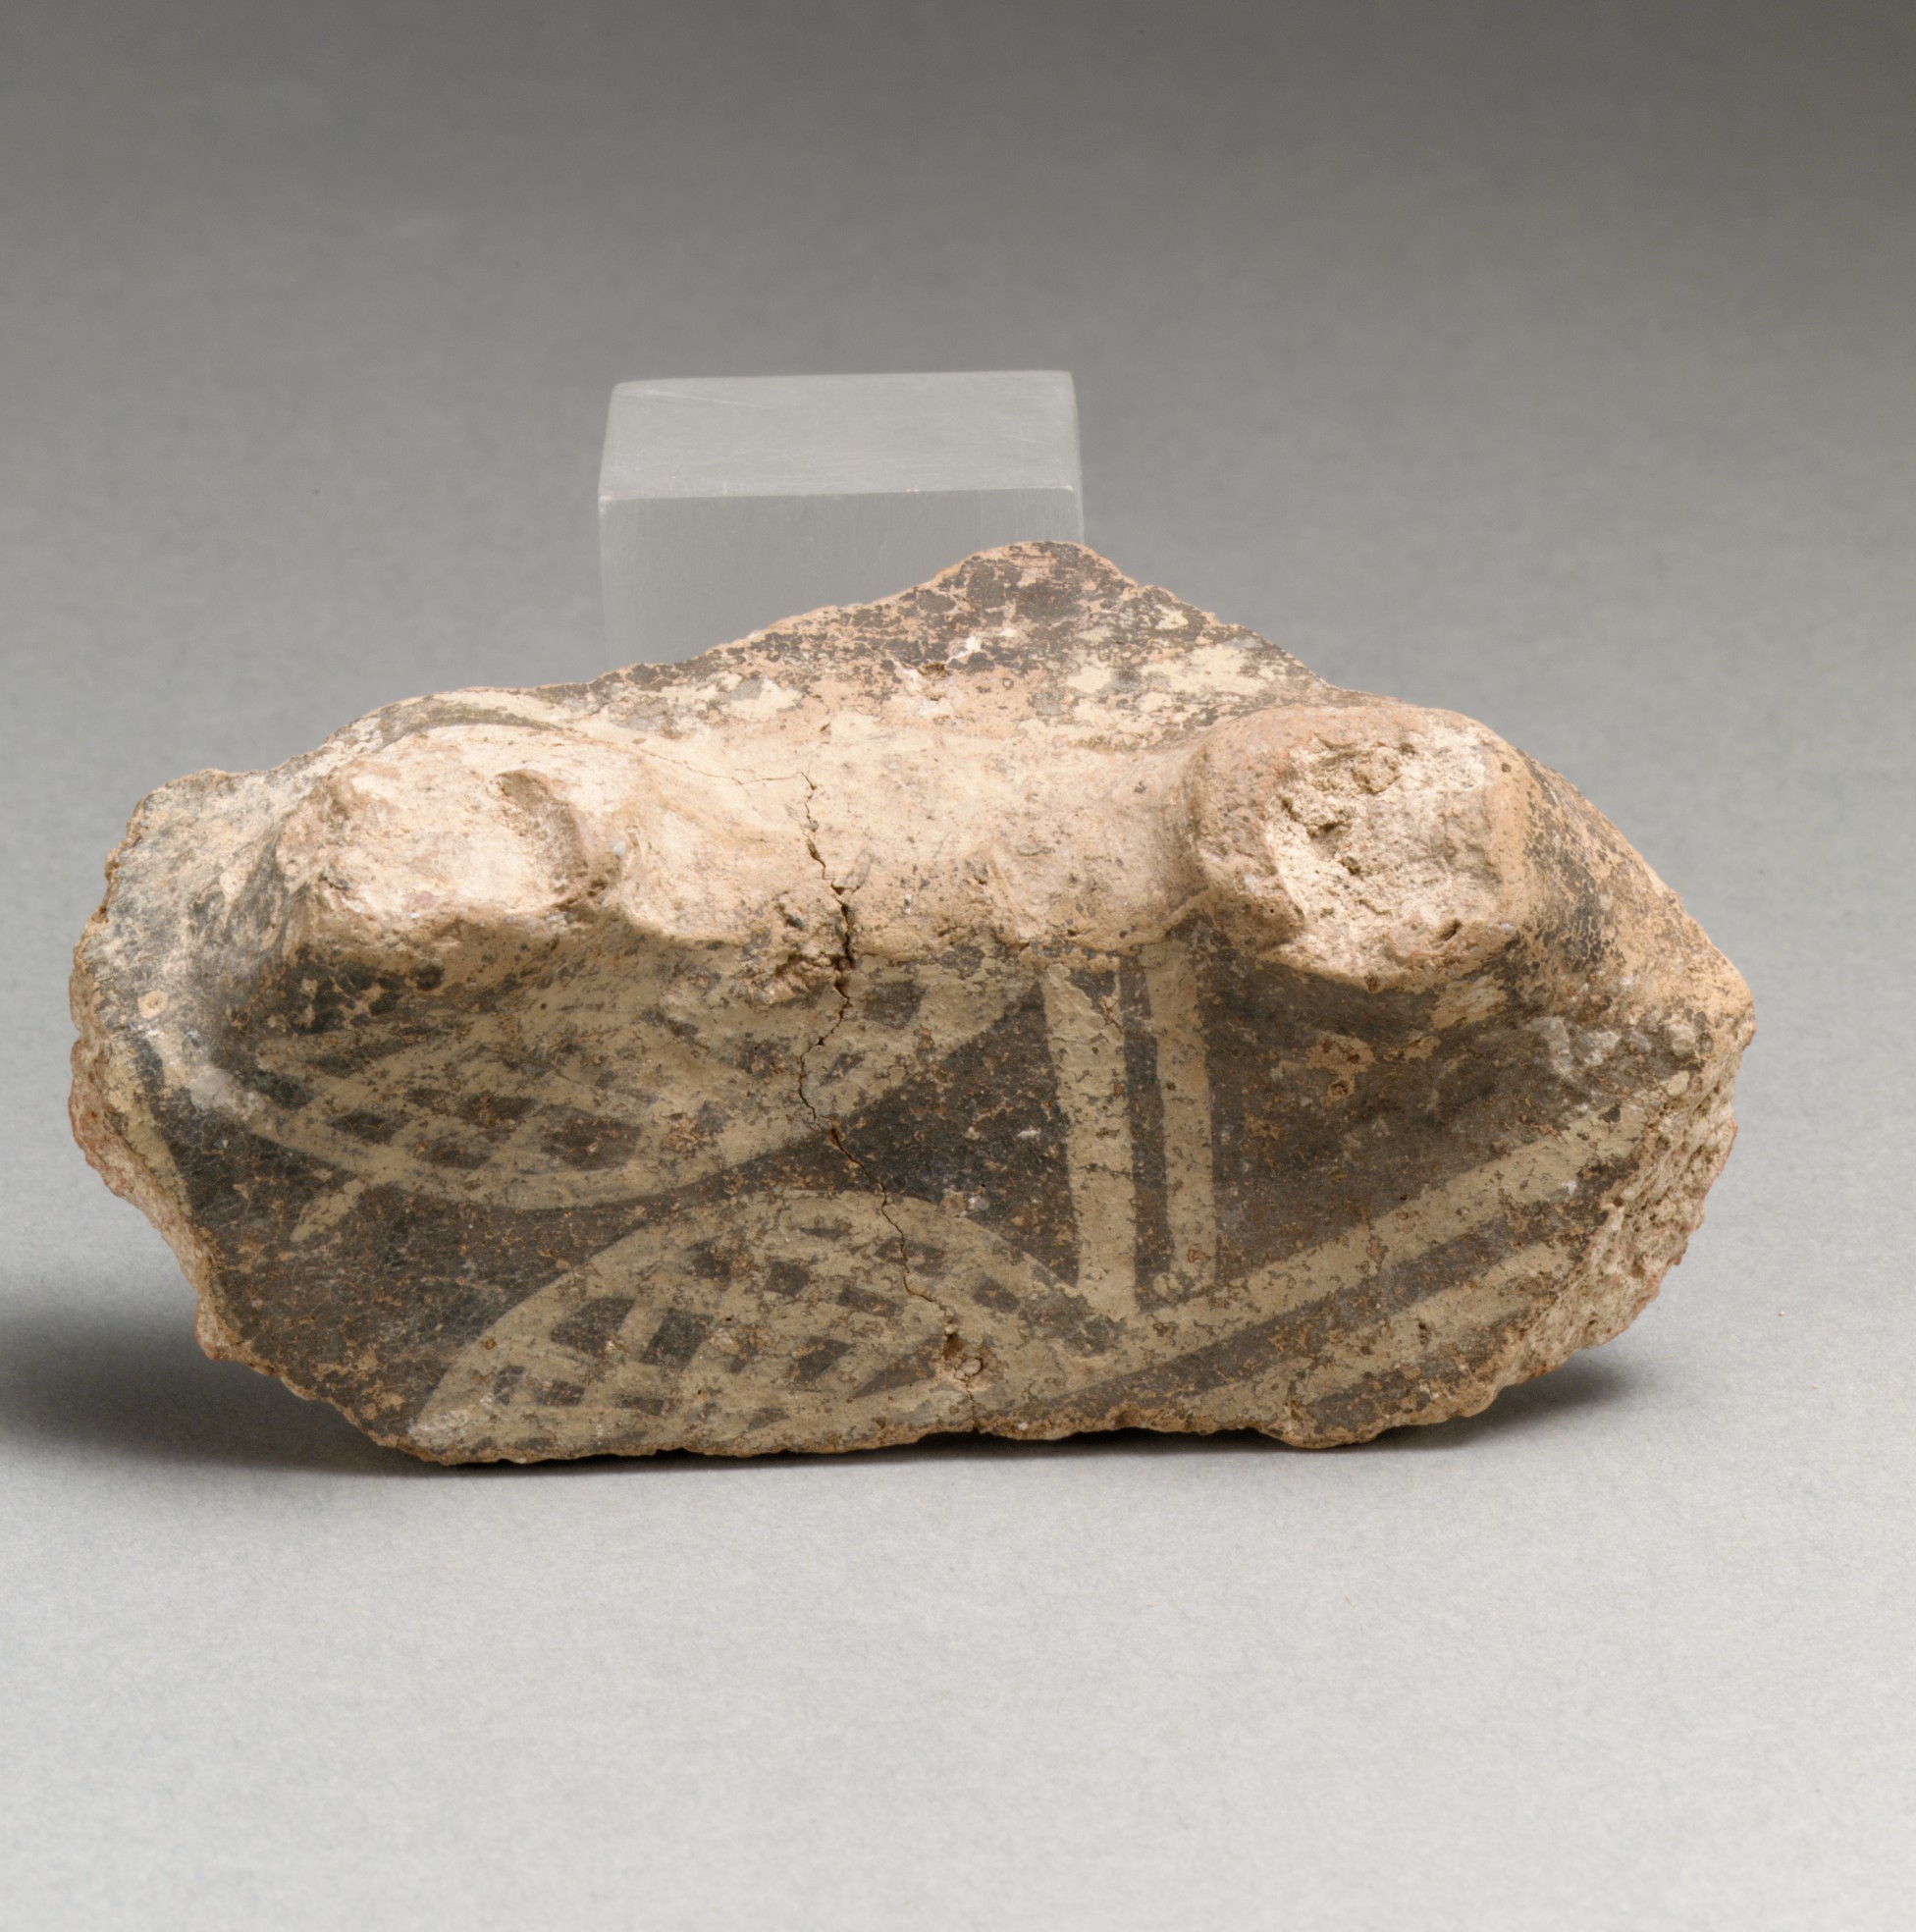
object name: vase fragment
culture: minoan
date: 2600-2000 BCE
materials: terracotta